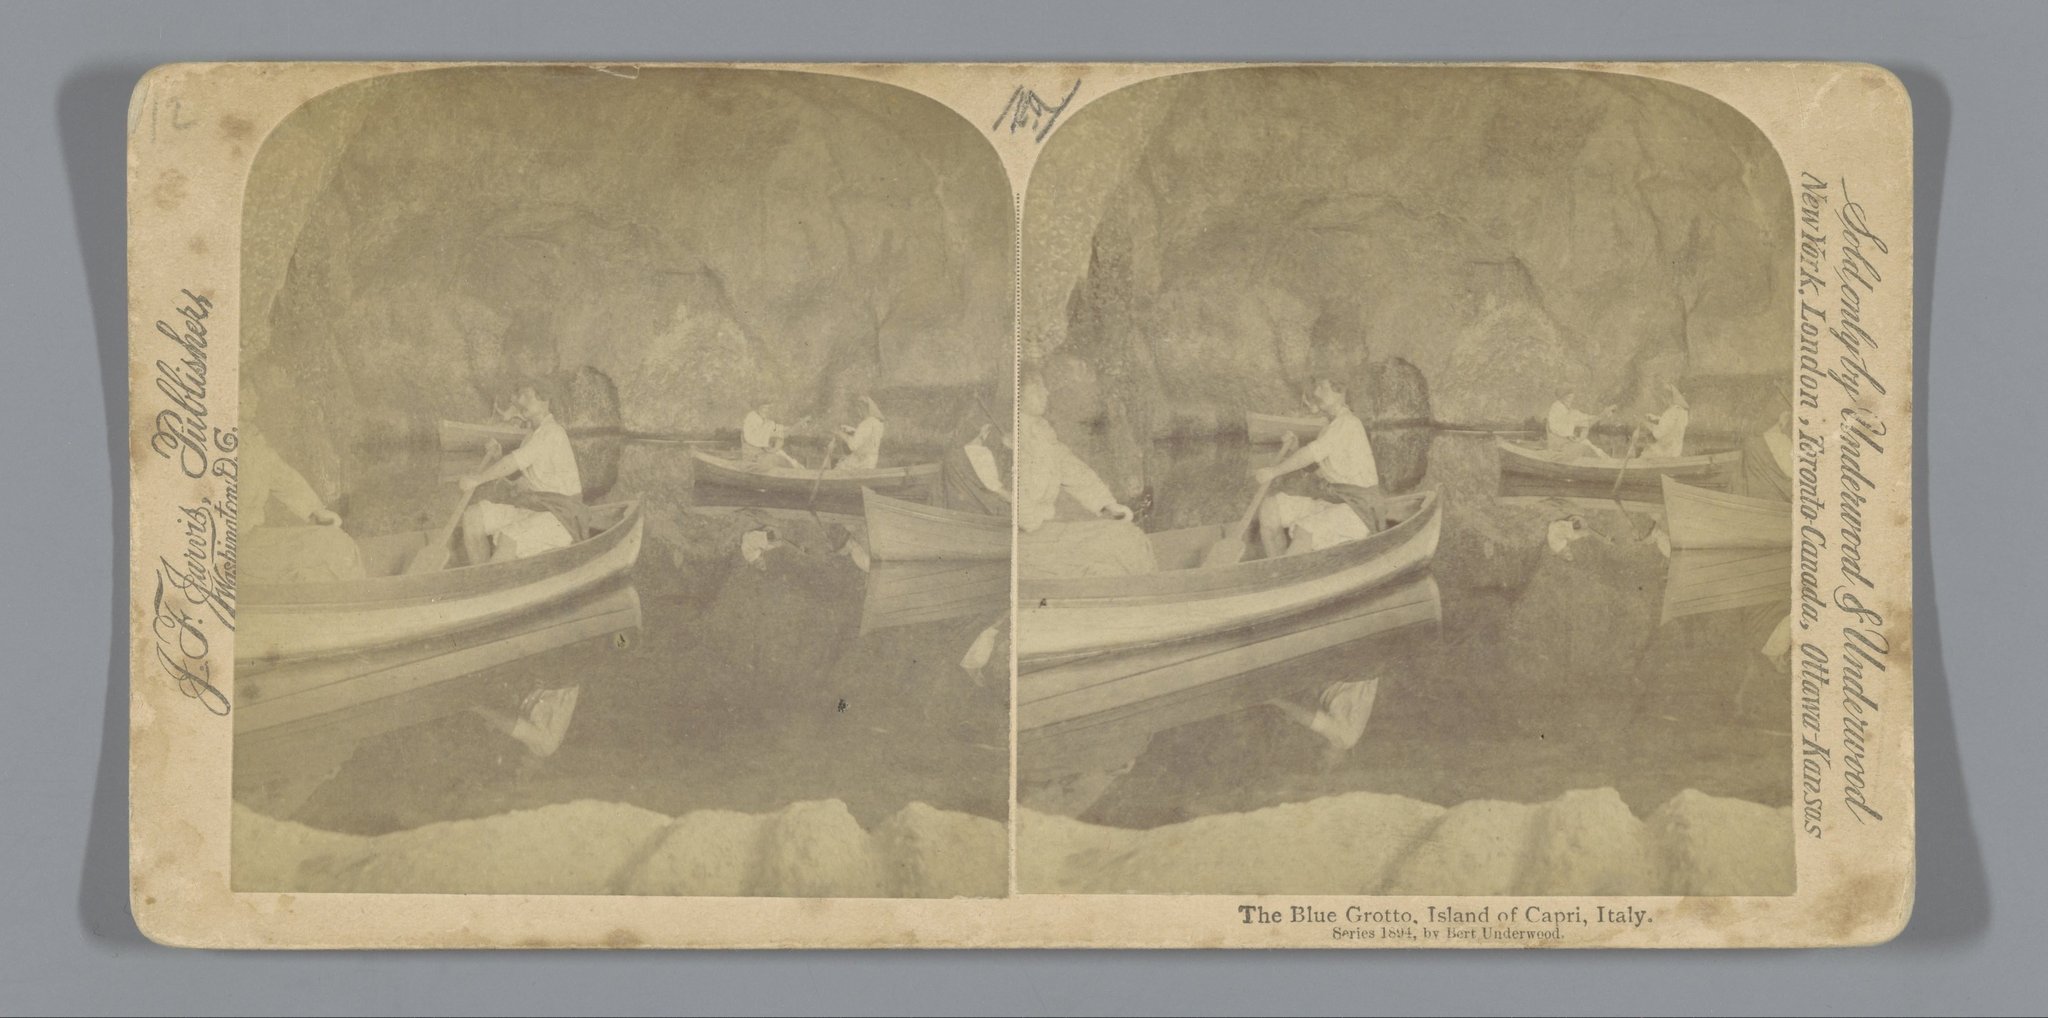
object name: stereograph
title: Roeiboten in de Blauwe Grot te Capri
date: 1894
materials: cardboard, photographic support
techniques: albumen print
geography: washington d.c.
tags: rowing-boat, canoe, etc., cave, grotto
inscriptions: name: ‘Sold only by Underwood & Underwood New York, London, Toronto-Canada, Ottawa-Kansas’